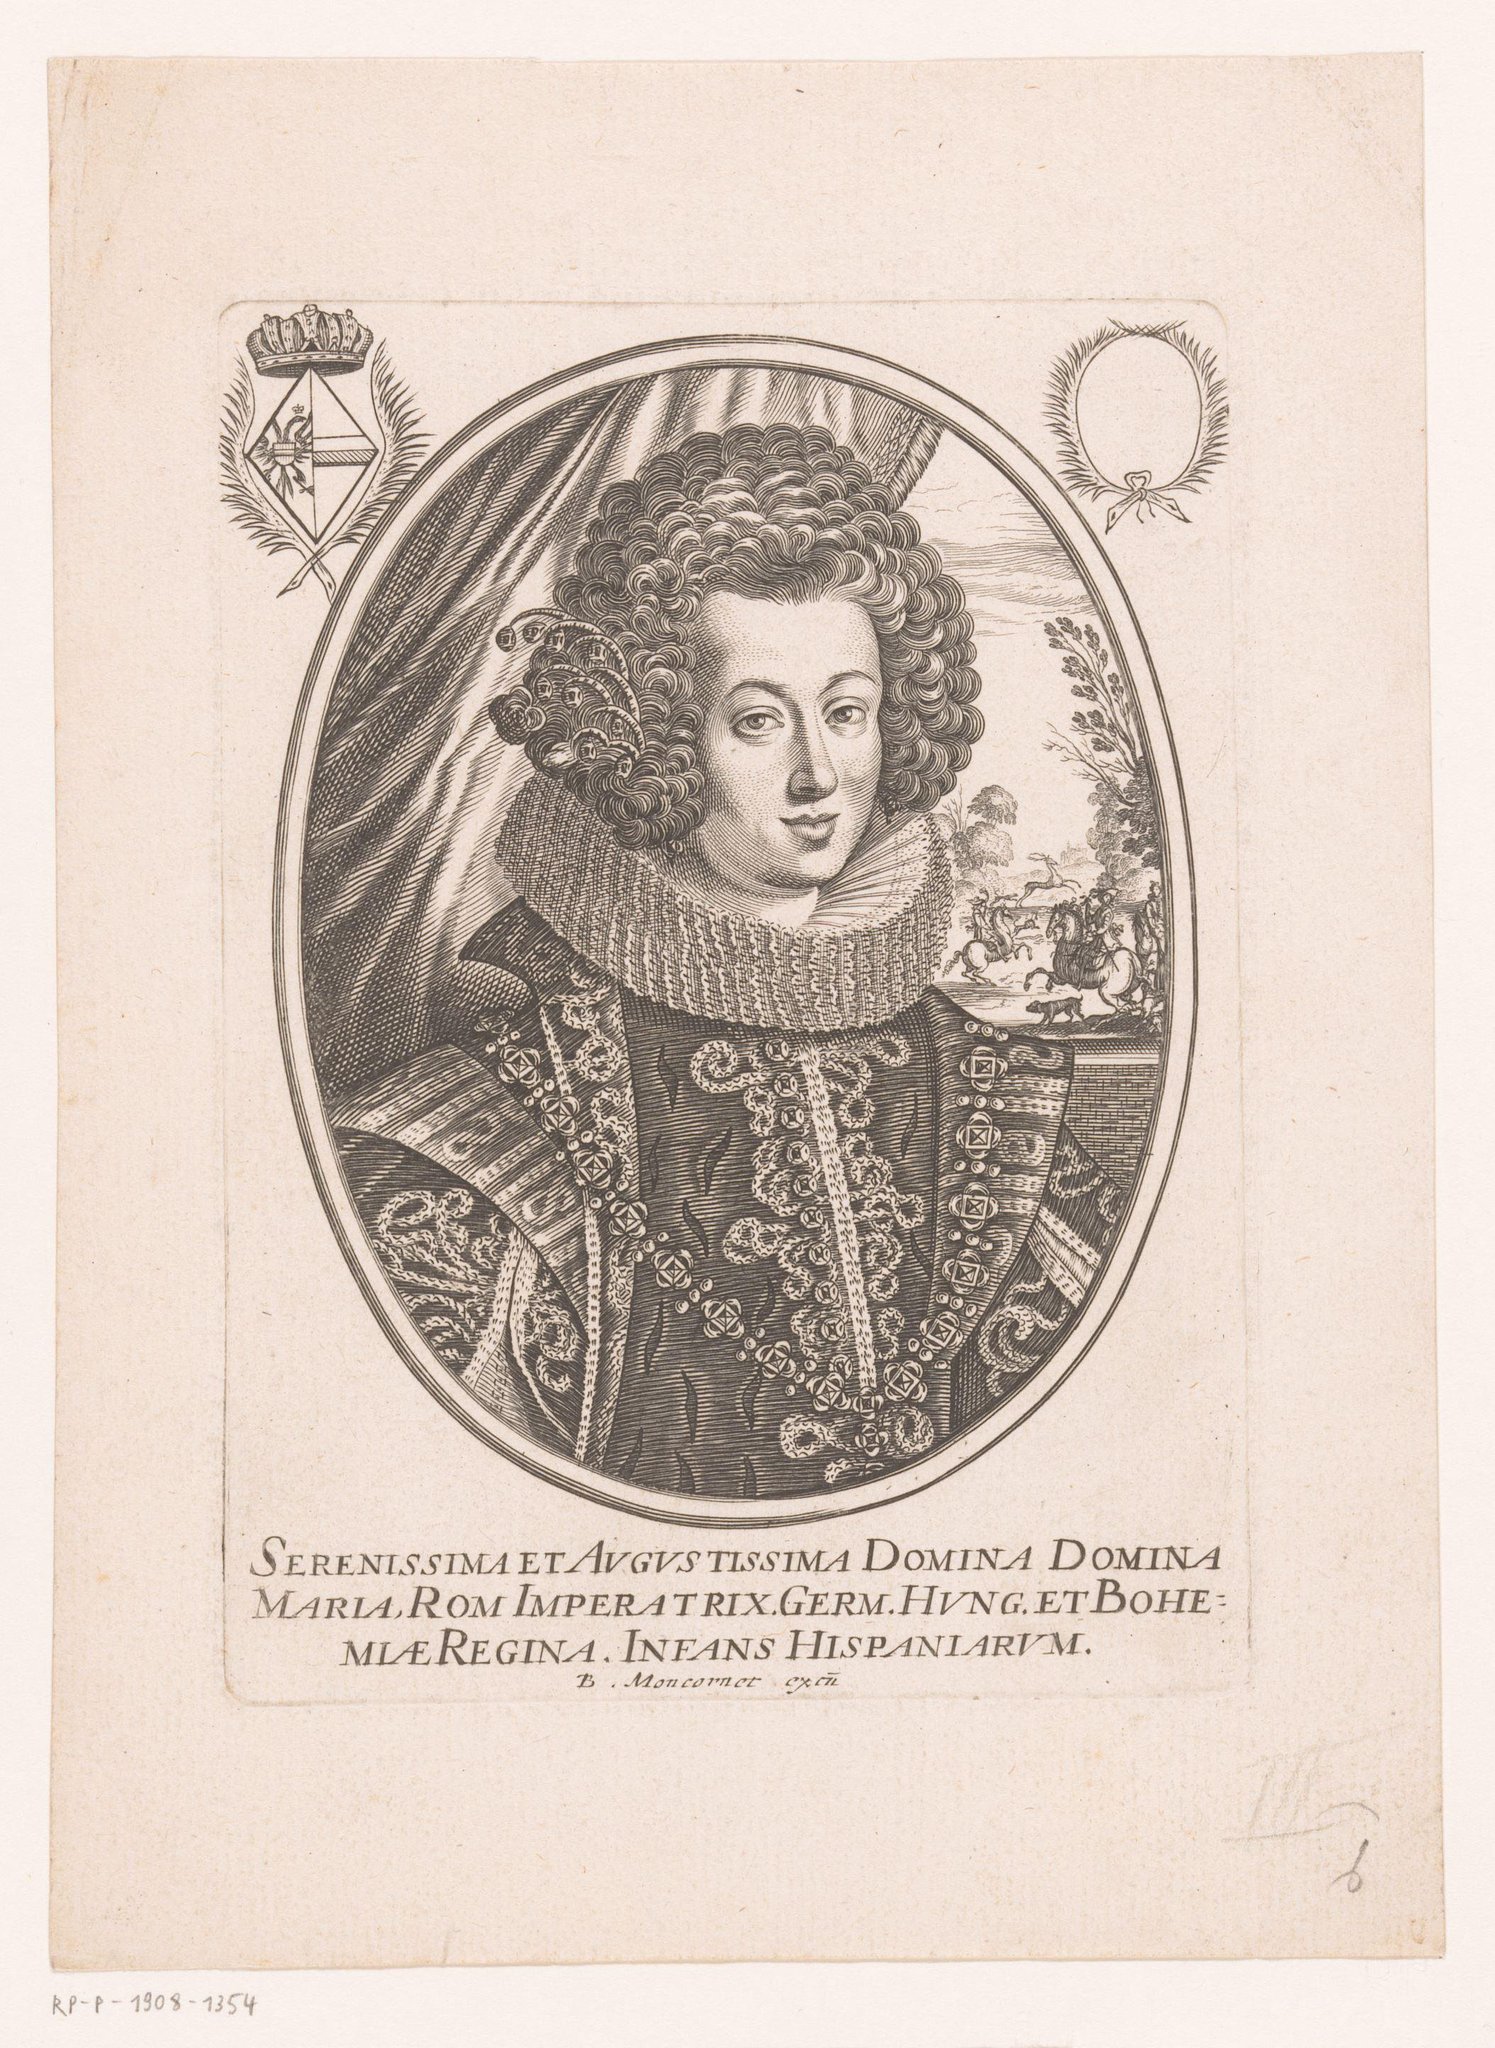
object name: print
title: Portret van Maria van Oostenrijk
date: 1626-1668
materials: paper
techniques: engraving, etching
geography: paris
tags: historical persons - bb - woman, emperor - bb - female ruler, armorial bearing, heraldry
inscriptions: collector's mark: Lugt 2228